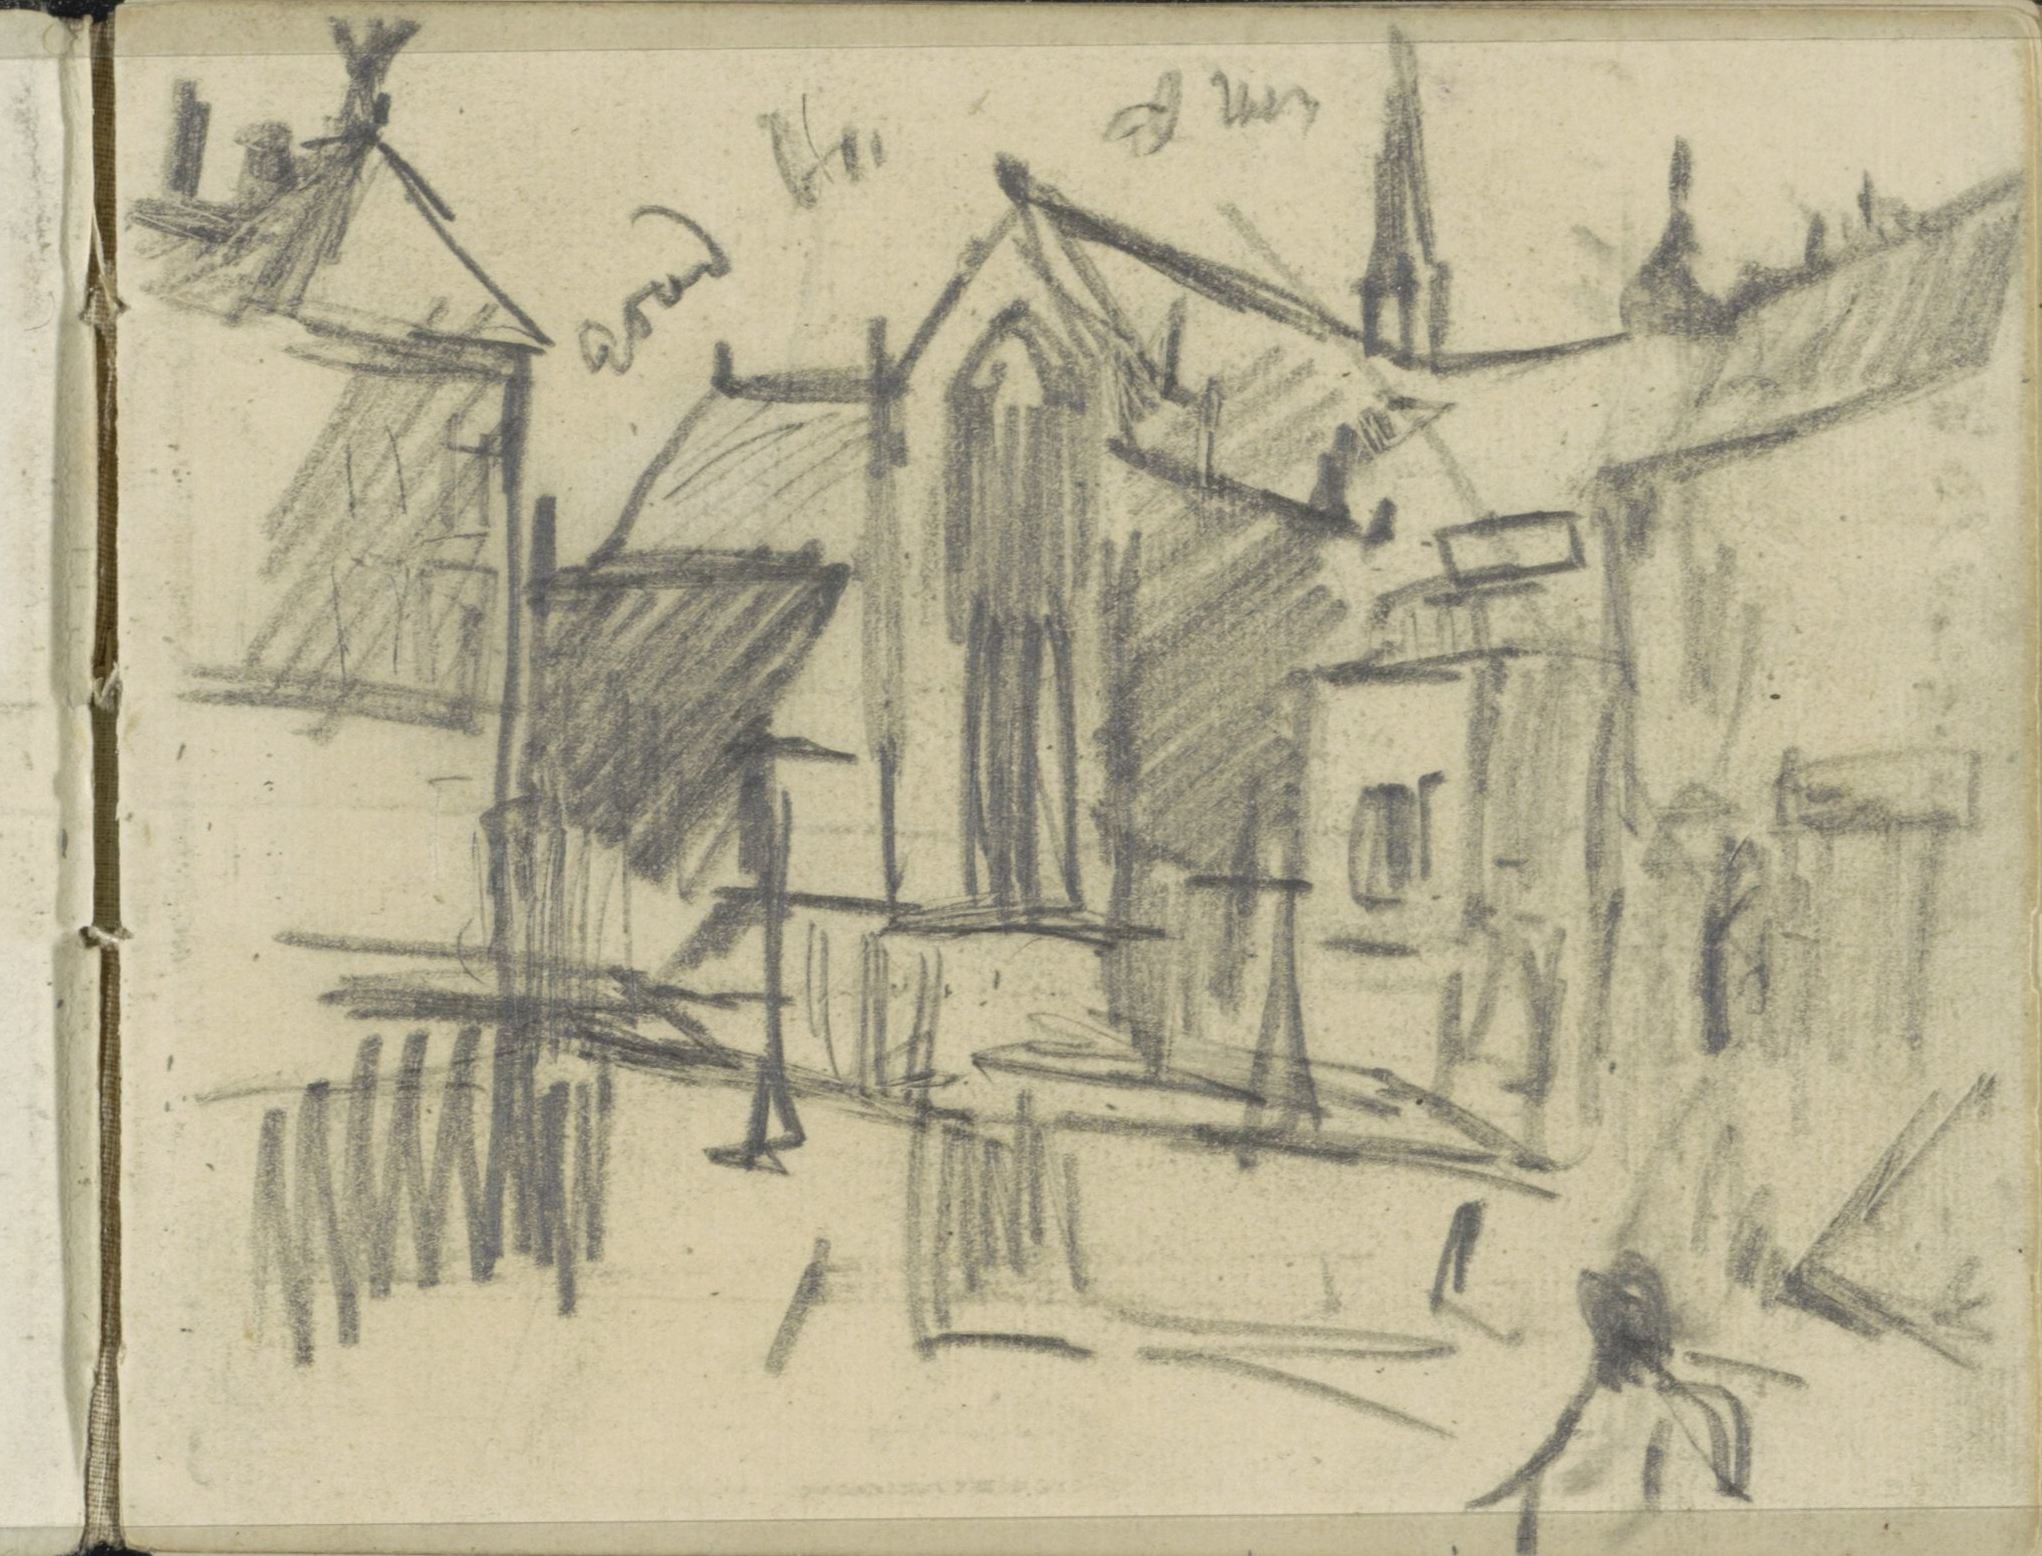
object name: sketchbook leaf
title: Gezicht op de Dam te Amsterdam met de Nieuwe Kerk en het Koninklijk Paleis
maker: george hendrik breitner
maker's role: draughtsman, painter, print maker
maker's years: 1857-1923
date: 1893-1912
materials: paper, pencil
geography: amsterdam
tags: church (exterior), square, place, circus, etc. (+ city(-scape) with figures, staffage), royal palace of amsterdam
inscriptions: kleurnotitie, handgeschreven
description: Gezien vanuit het Commandantshuis. Pagina 2 uit een schetsboek met 32 bladen.